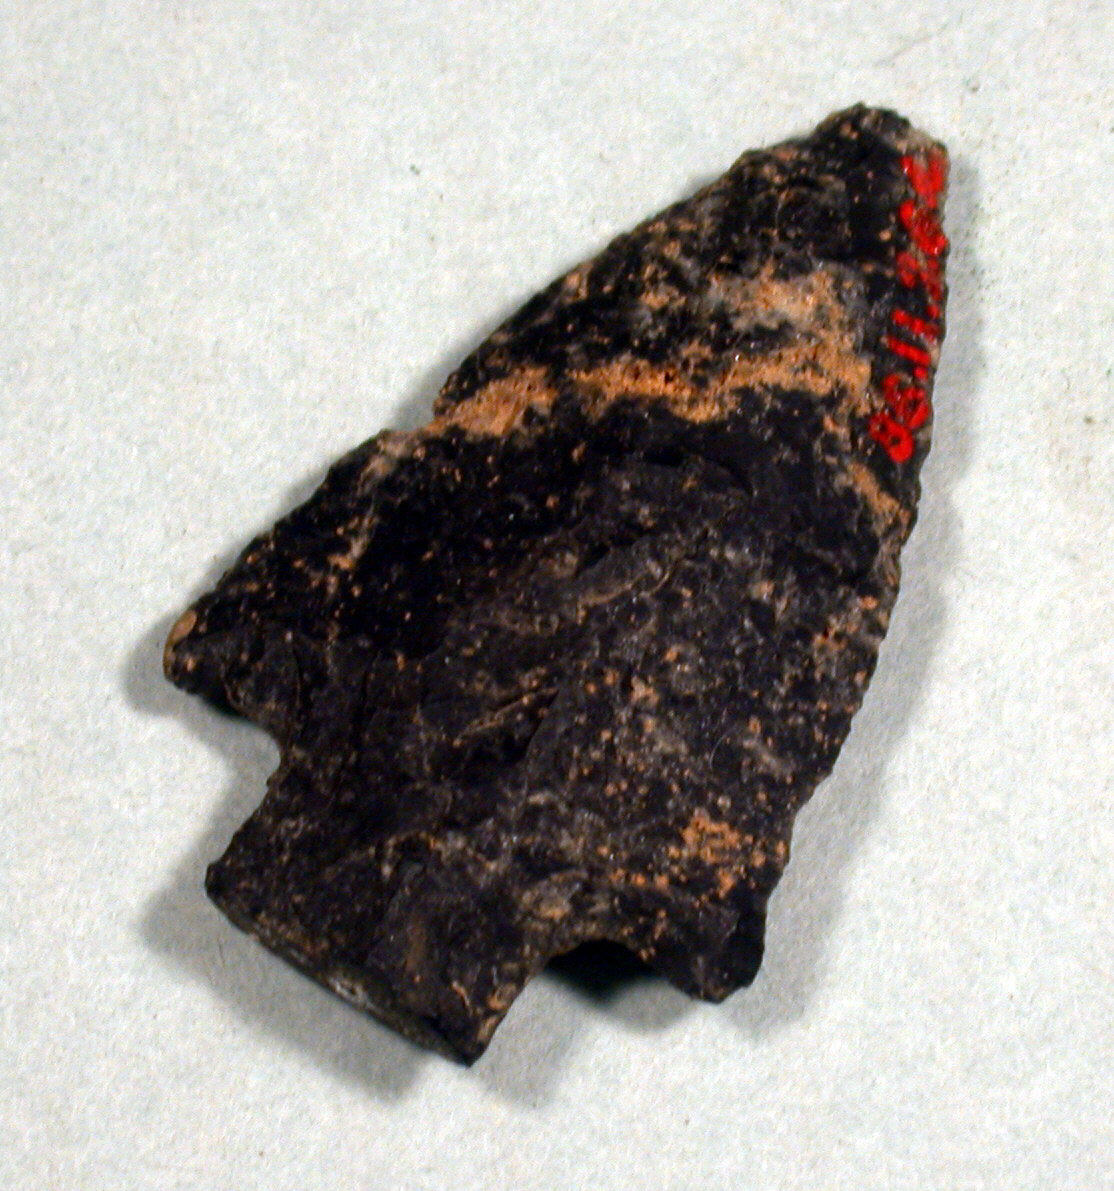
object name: point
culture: western asian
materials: stone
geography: western asia